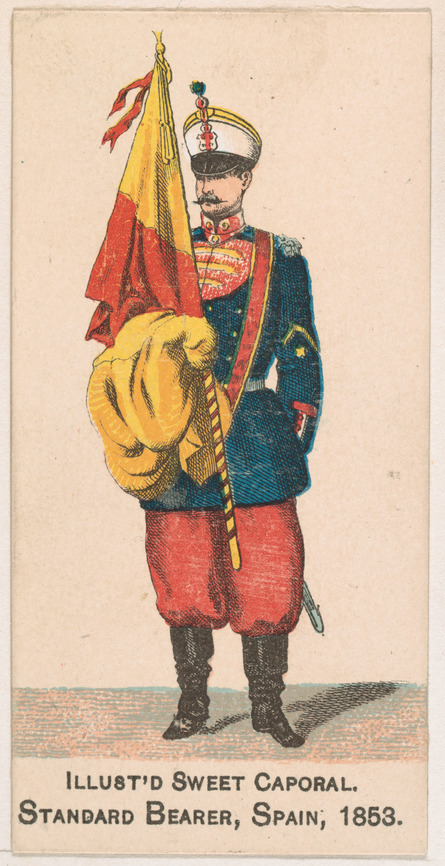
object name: print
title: Standard Bearer, Spain, 1853, from the Military Series (N224) issued by Kinney Tobacco Company to promote Sweet Caporal Cigarettes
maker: kinney brothers tobacco company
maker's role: publisher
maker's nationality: american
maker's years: 1869-2011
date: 1888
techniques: color lithograph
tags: military,men,flags